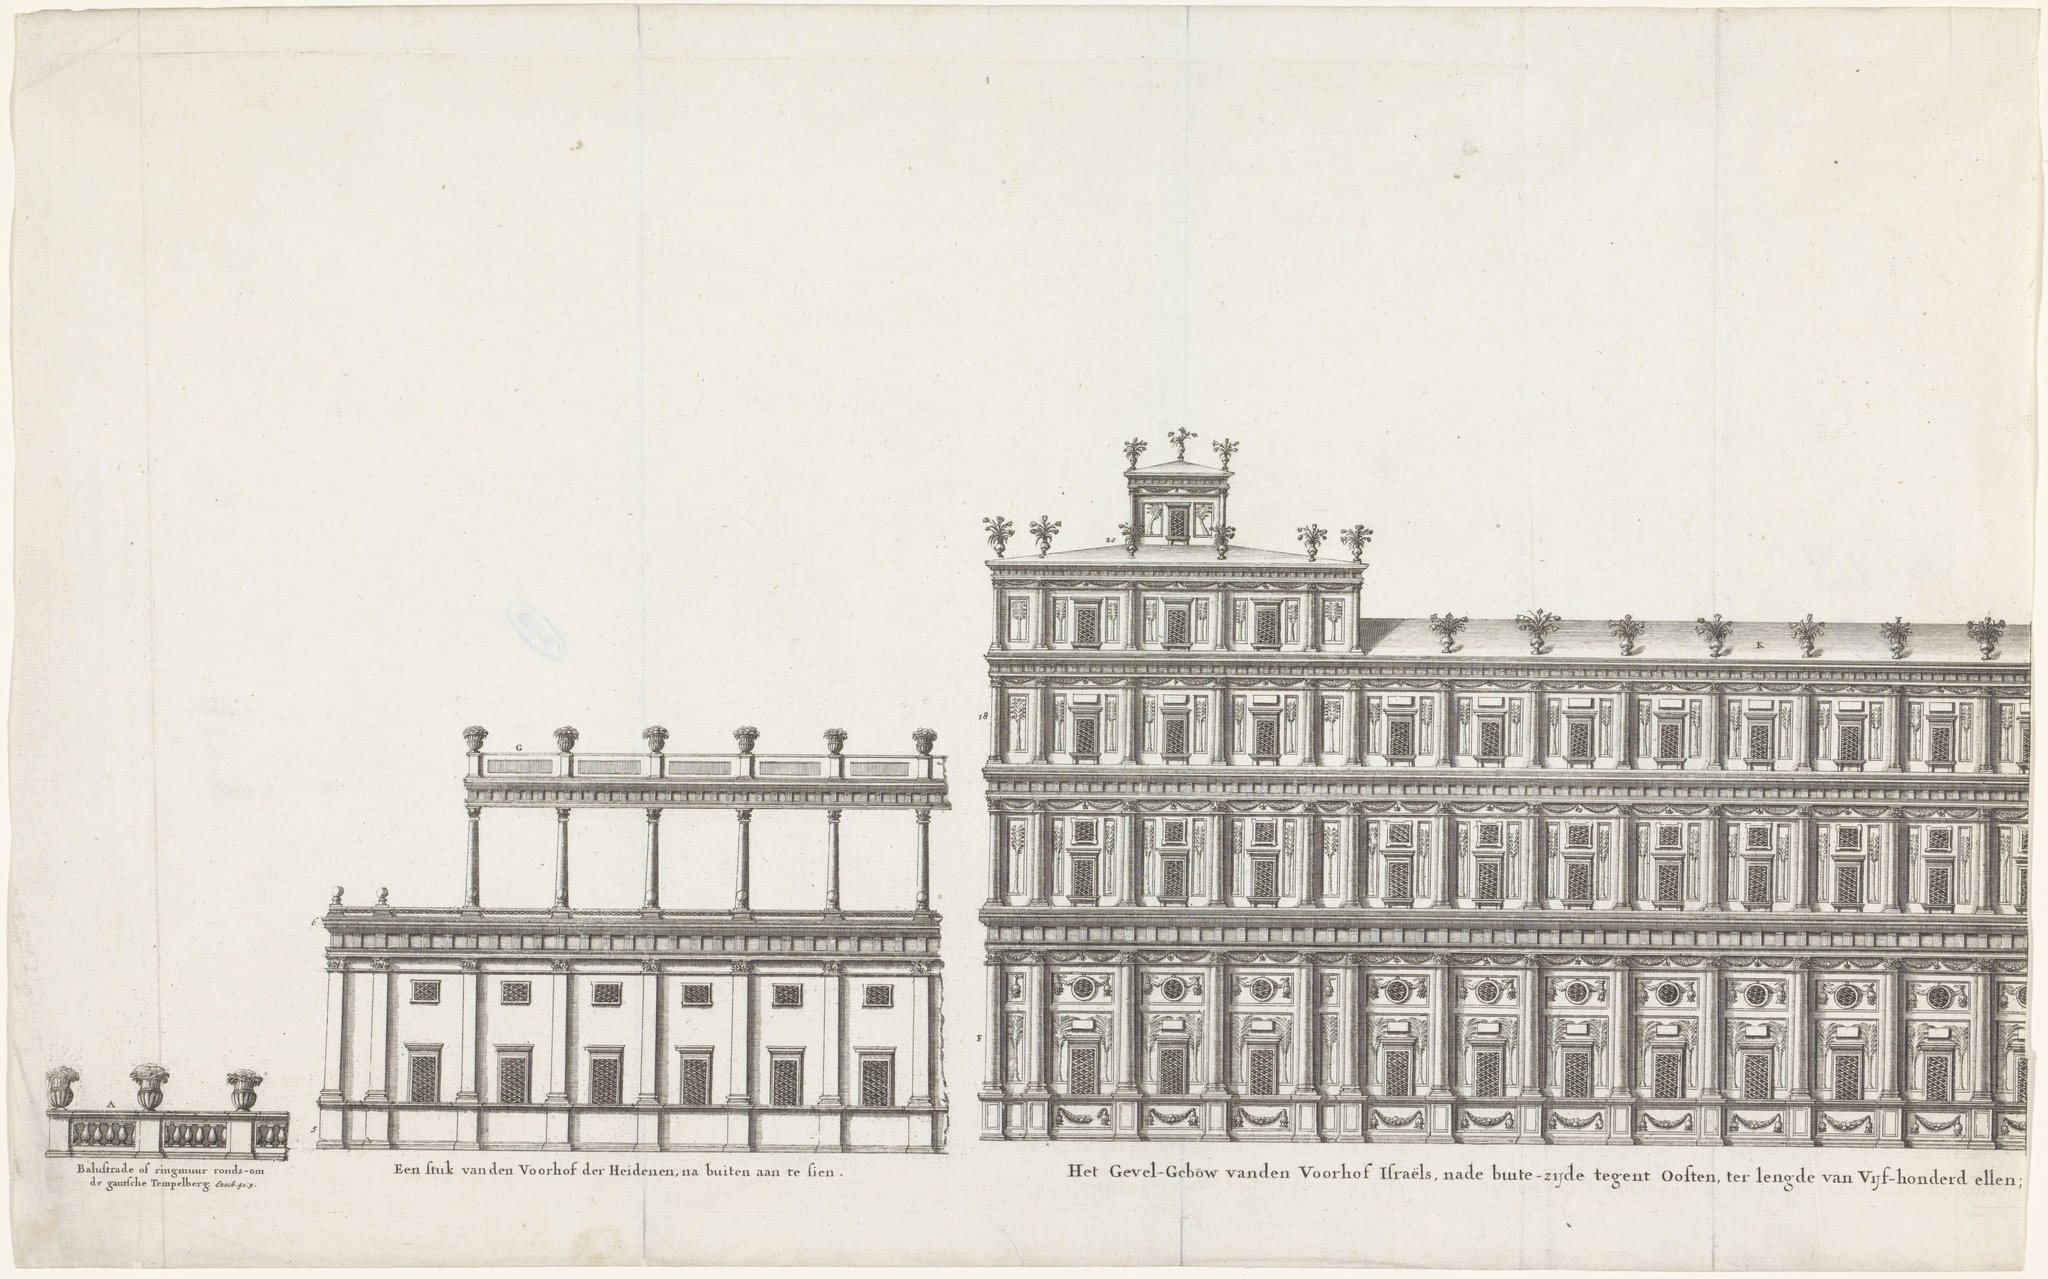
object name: print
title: Voorgevel van de nieuwe tempel (links)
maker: Anonymous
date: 1618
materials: paper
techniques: etching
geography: netherlands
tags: outer court of jewish temple, with gates and stairs, temple of solomon (1 kings 5-9; 2 chronicles 2-7)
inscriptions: collector's mark: Lugt 2228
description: Het linkerdeel van de gevel van de nieuwe tempel te Jeruzalem, zoals deze eruit zou zien volgens Juan Bautista Villalpando in zijn boek Ezechielem Explanationes, 1596. Villalpando baseerde zich op de visioenen van Ezechiël over de nieuwe tempel in het Bijbelboek Ezechiël. Links een balustrade en de voorgevel van de voorhof van de heidenen.